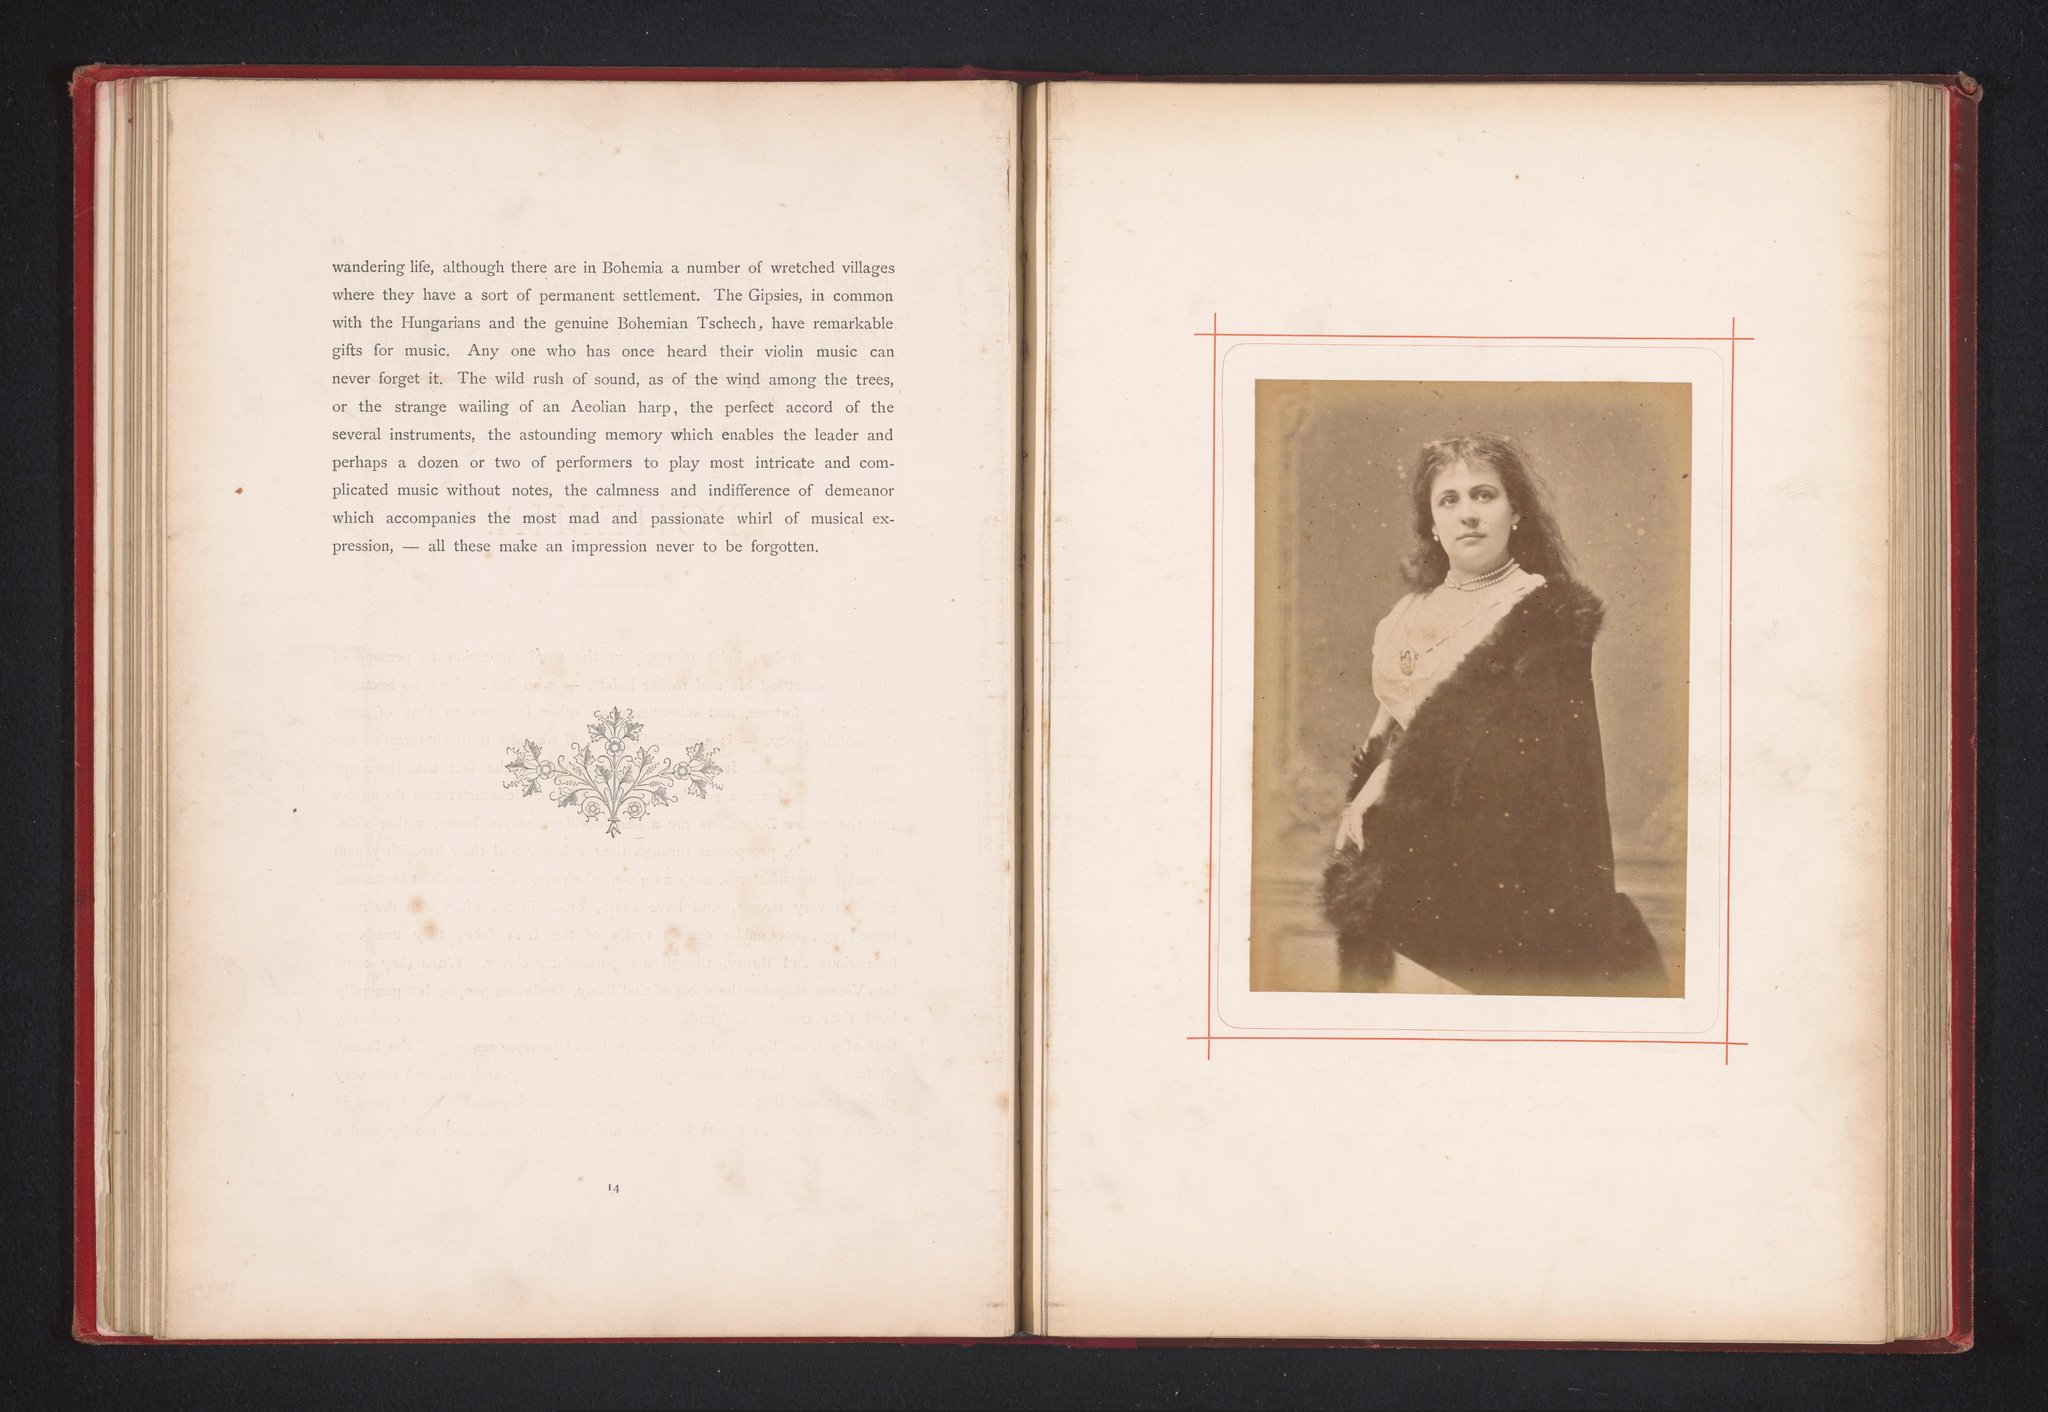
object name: page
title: Portret van een onbekende vrouw in klederdracht uit Polen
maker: Anonymous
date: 1876-1886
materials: photographic support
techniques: albumen print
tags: folk costume, regional costume, anonymous historical person portrayed - bb - woman